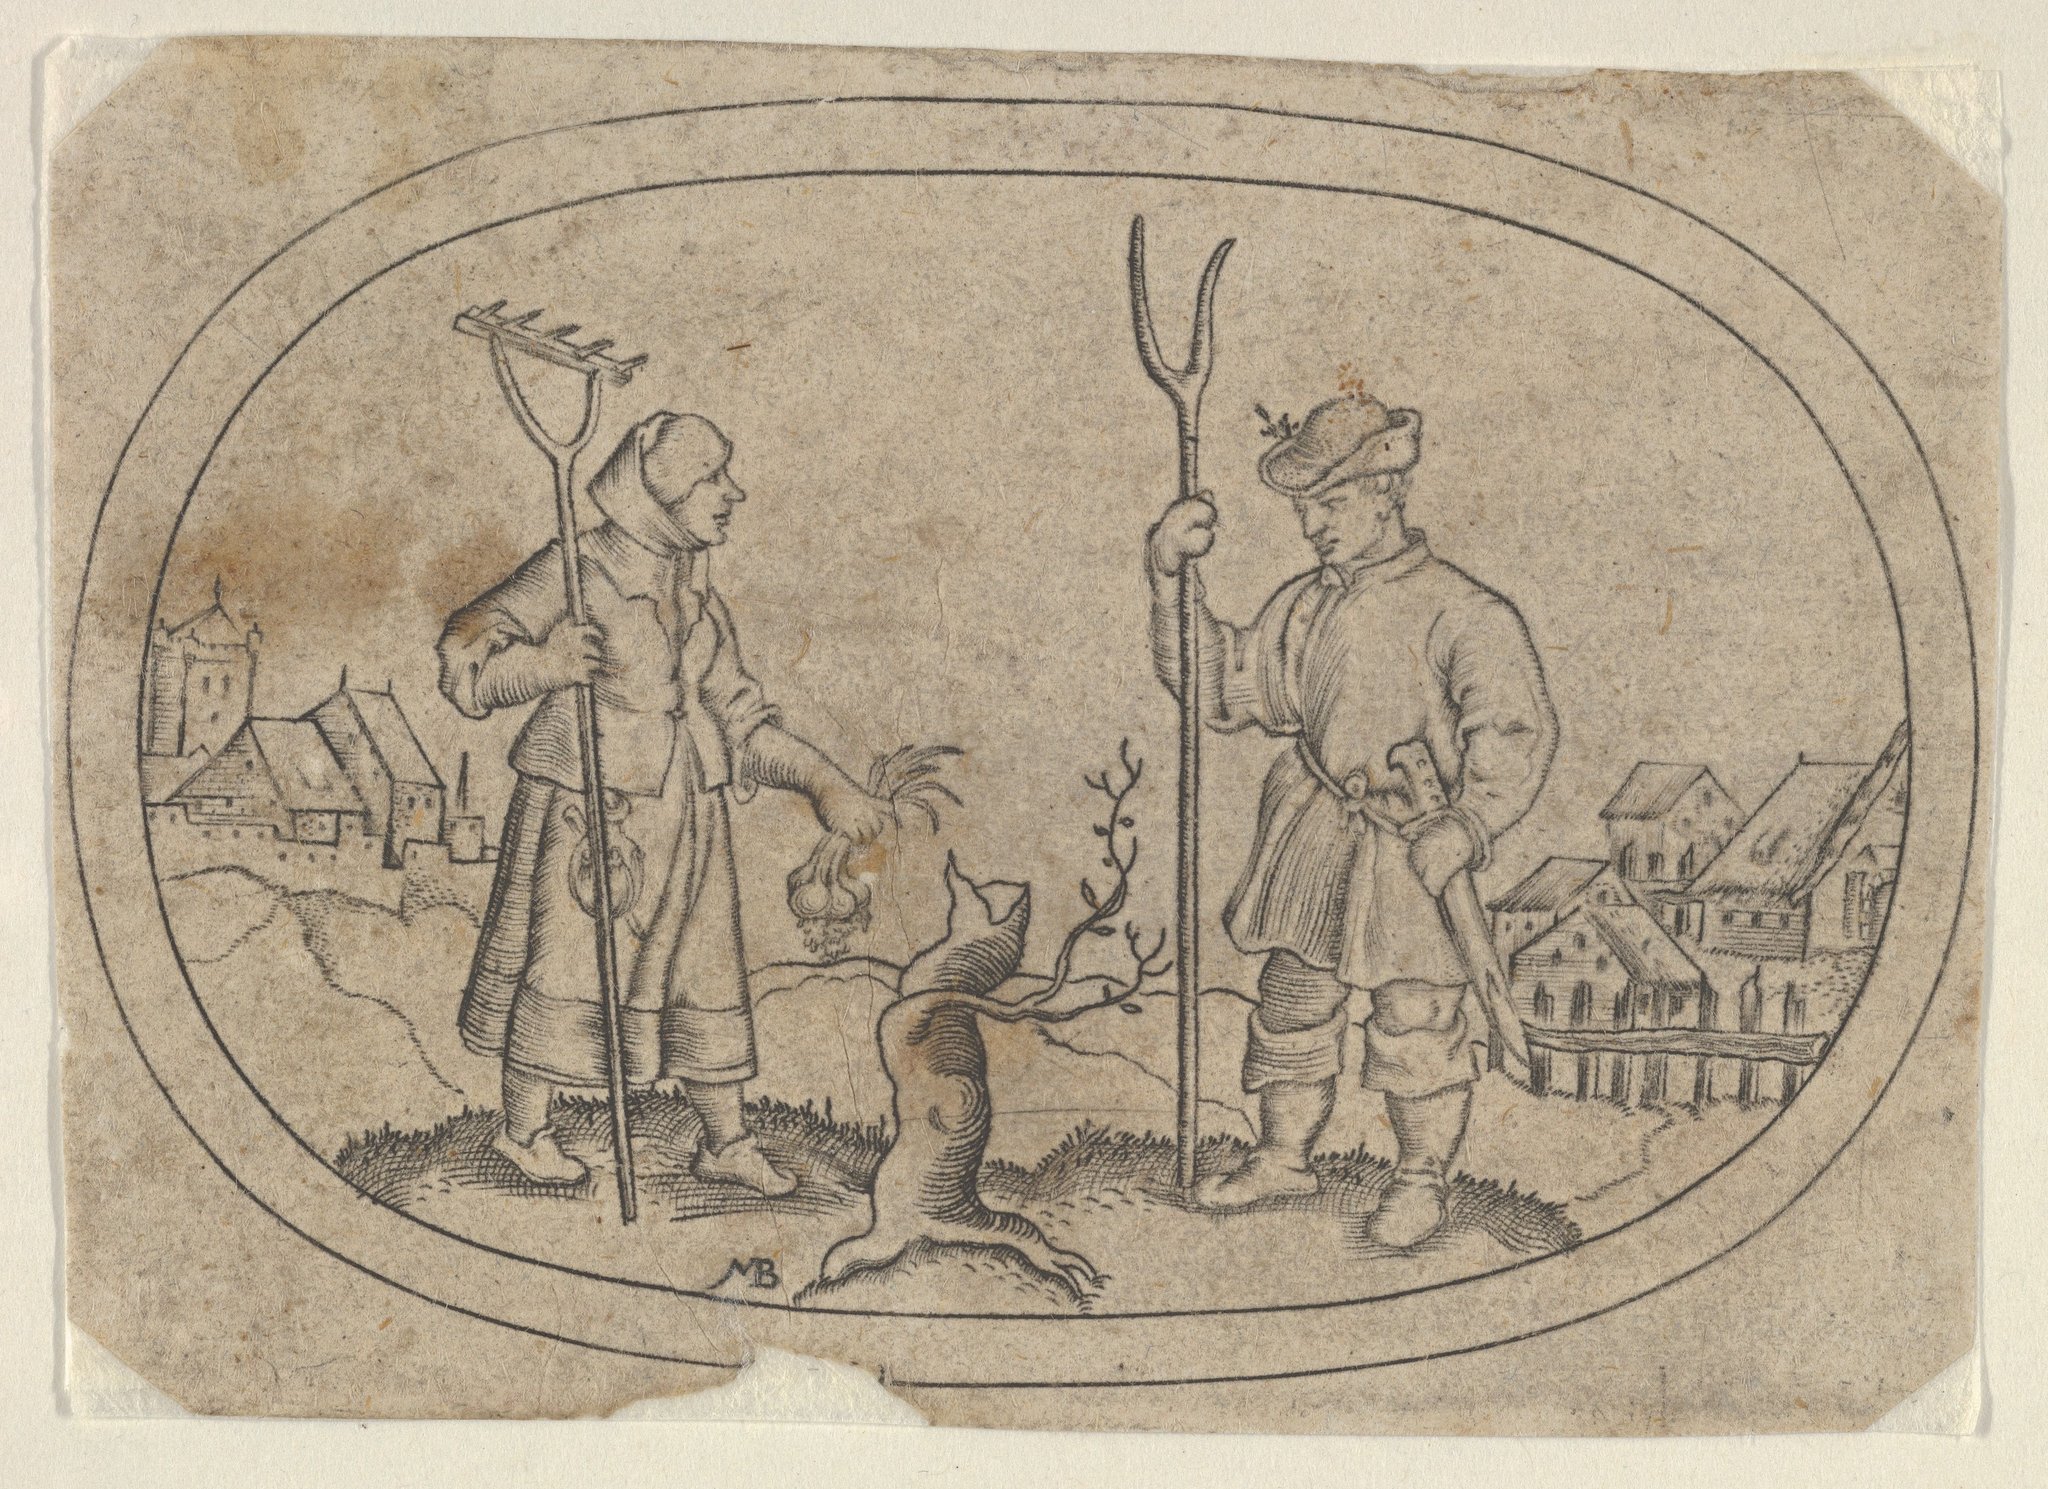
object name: print ornament architecture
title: A Farmer and a Villager, from Das Bossenbüchlein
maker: mathais beitler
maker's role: artist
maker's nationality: german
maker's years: 1582-1616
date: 1582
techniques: engraving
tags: men,women,farmers